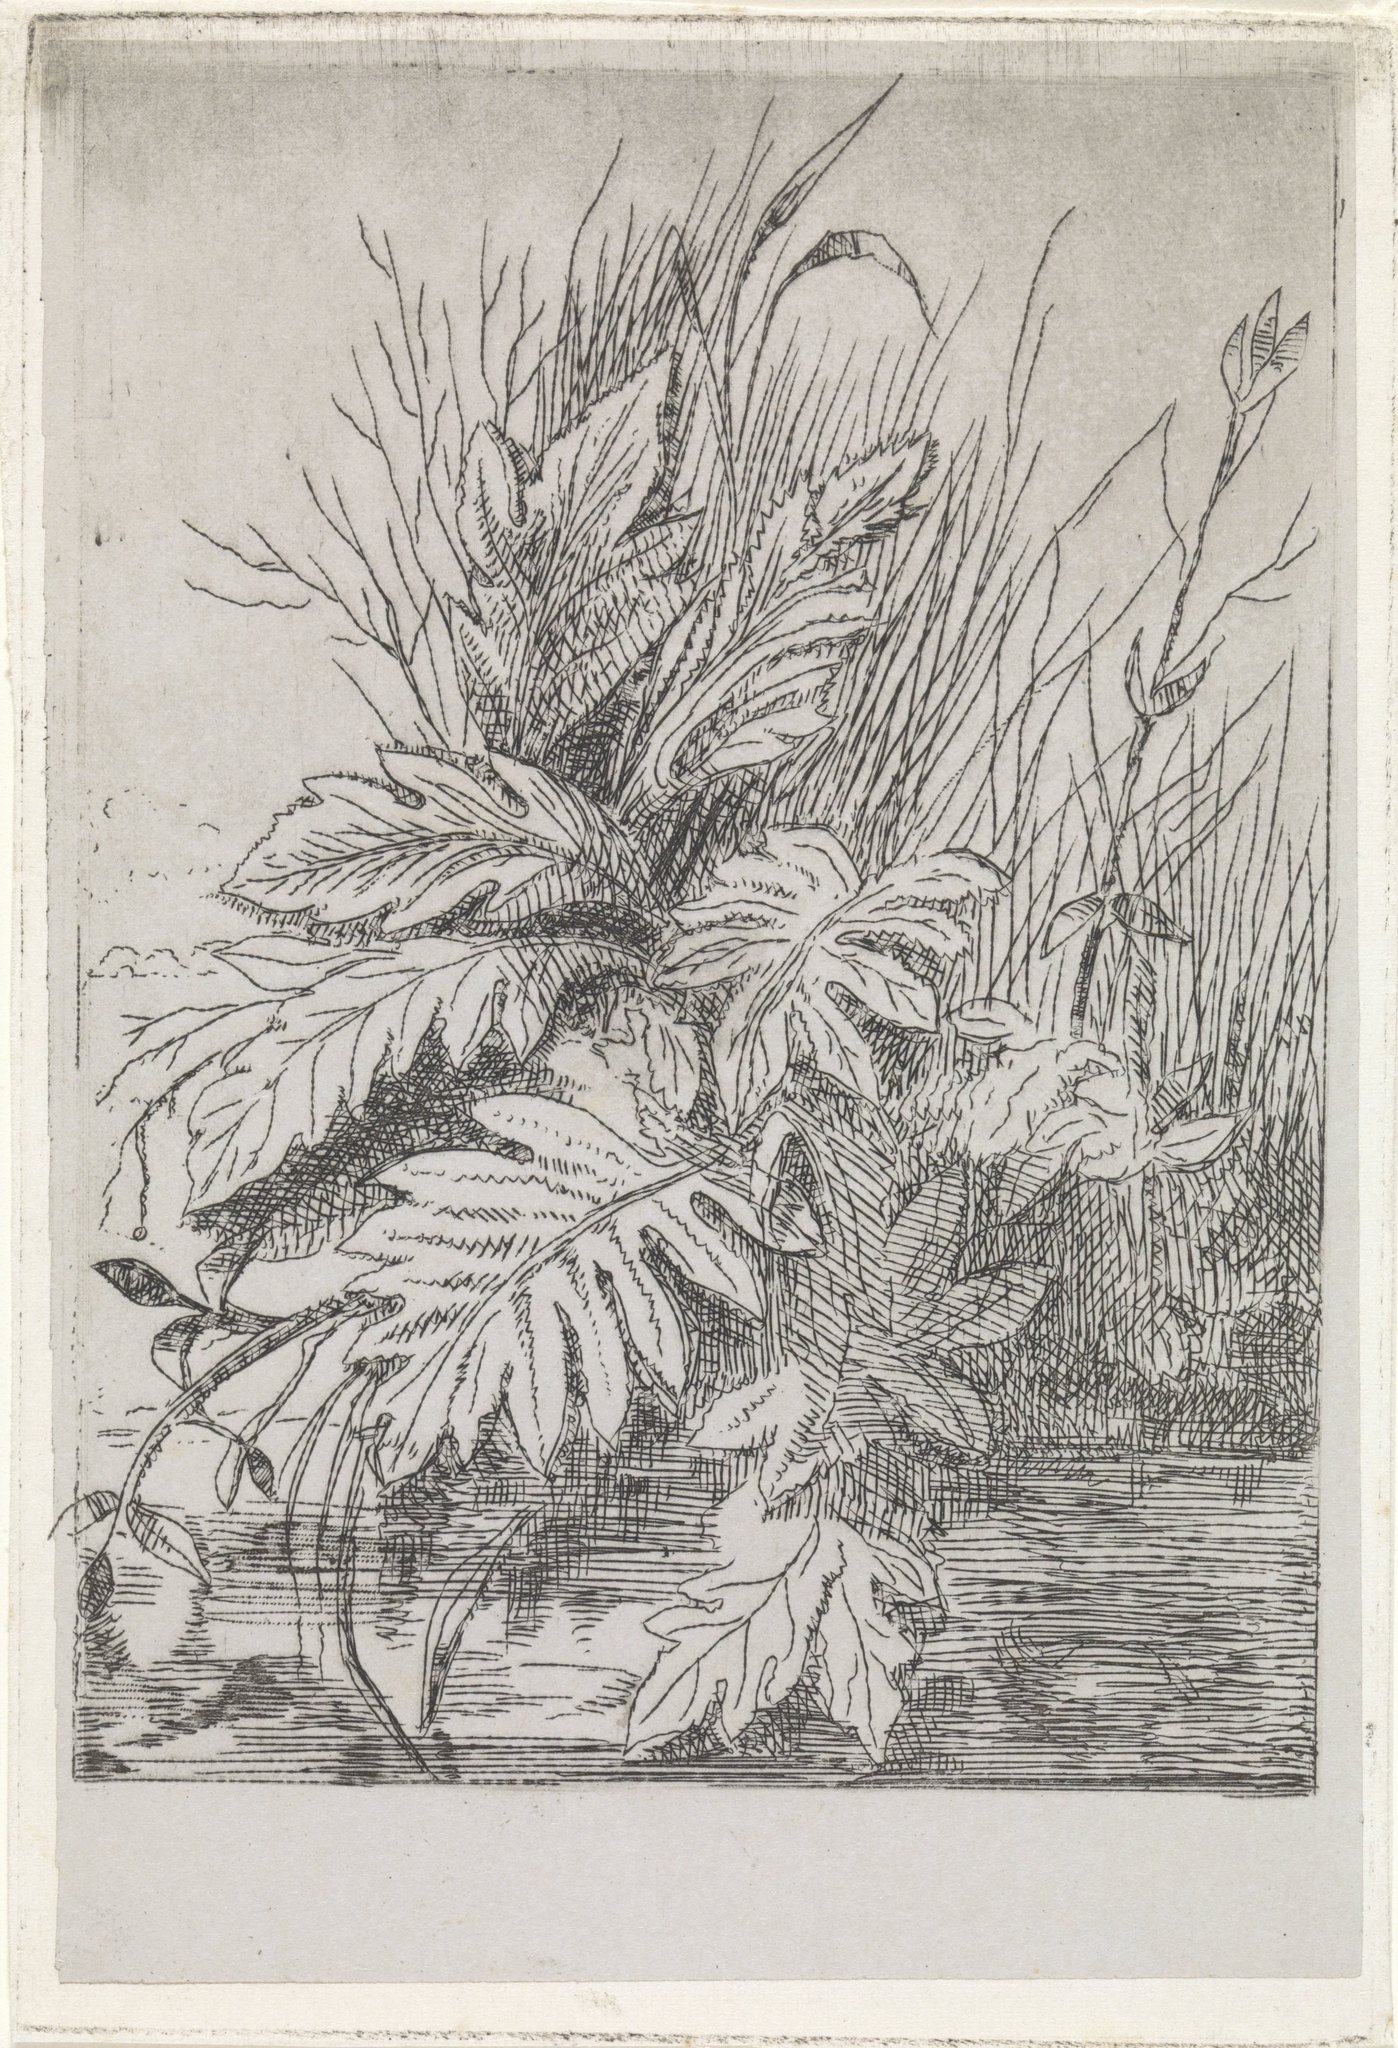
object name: print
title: Planten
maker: arnoud schaepkens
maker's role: print maker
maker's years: 1816-1904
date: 1831-1904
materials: paper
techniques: drypoint, etching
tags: plants and herbs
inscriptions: collector's mark: Lugt 2228